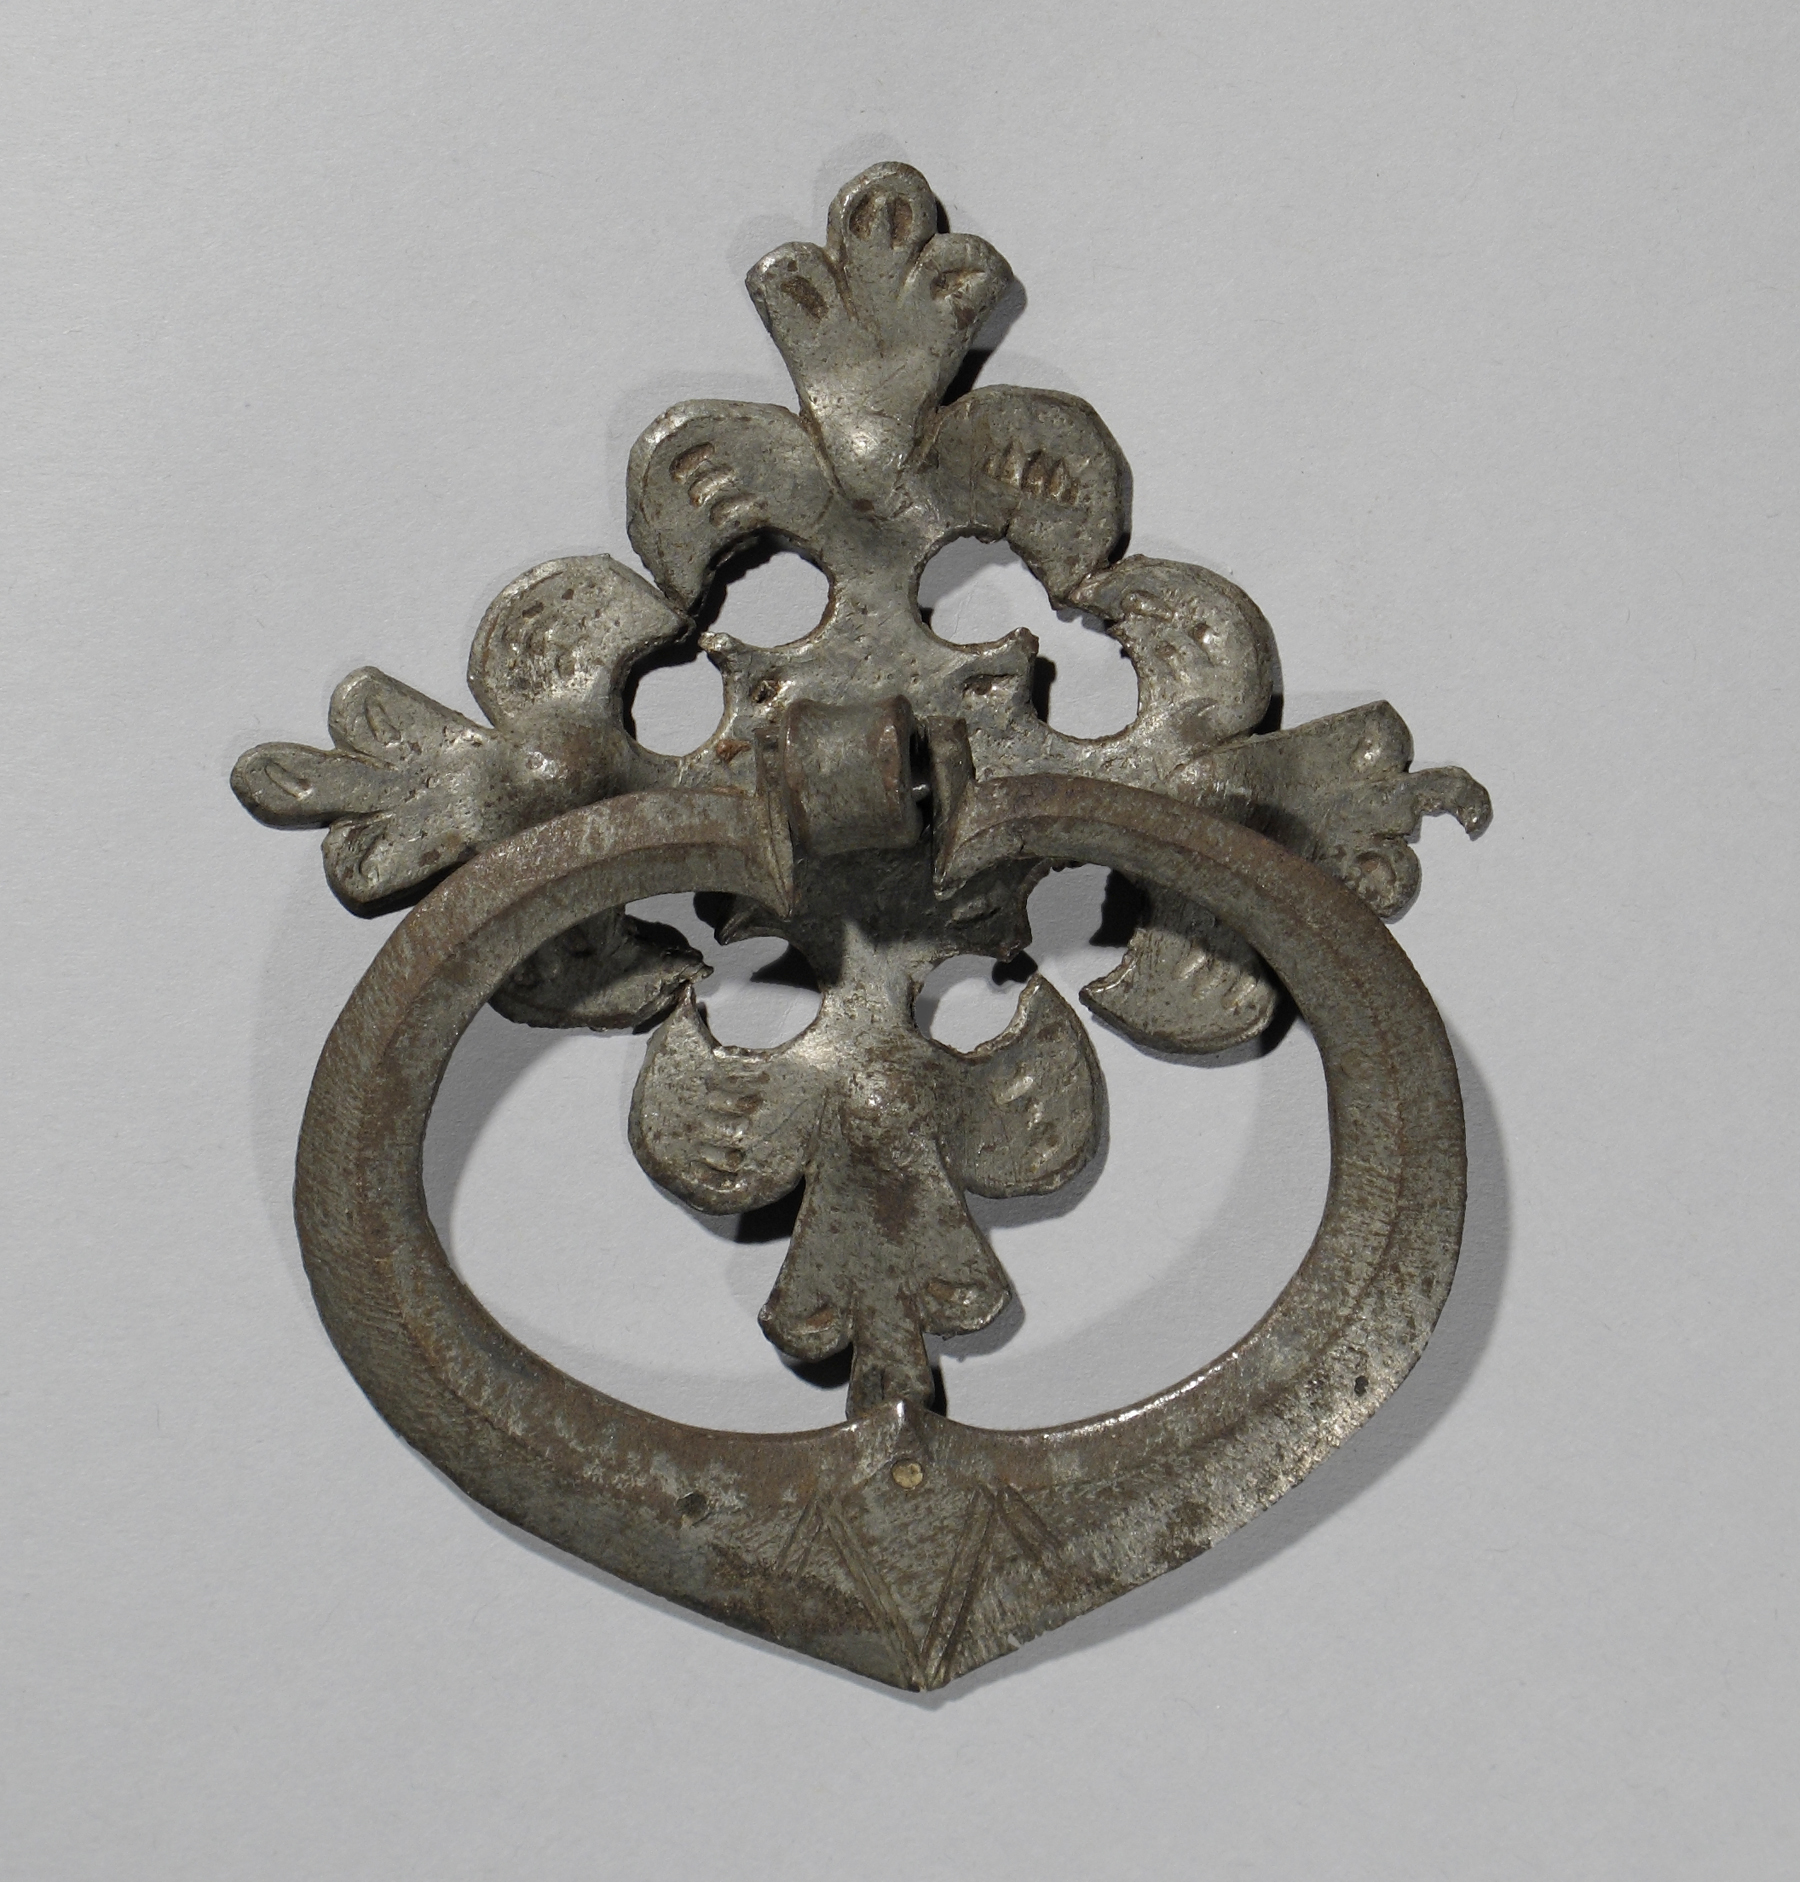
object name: door knocker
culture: european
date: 1401-1600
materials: iron